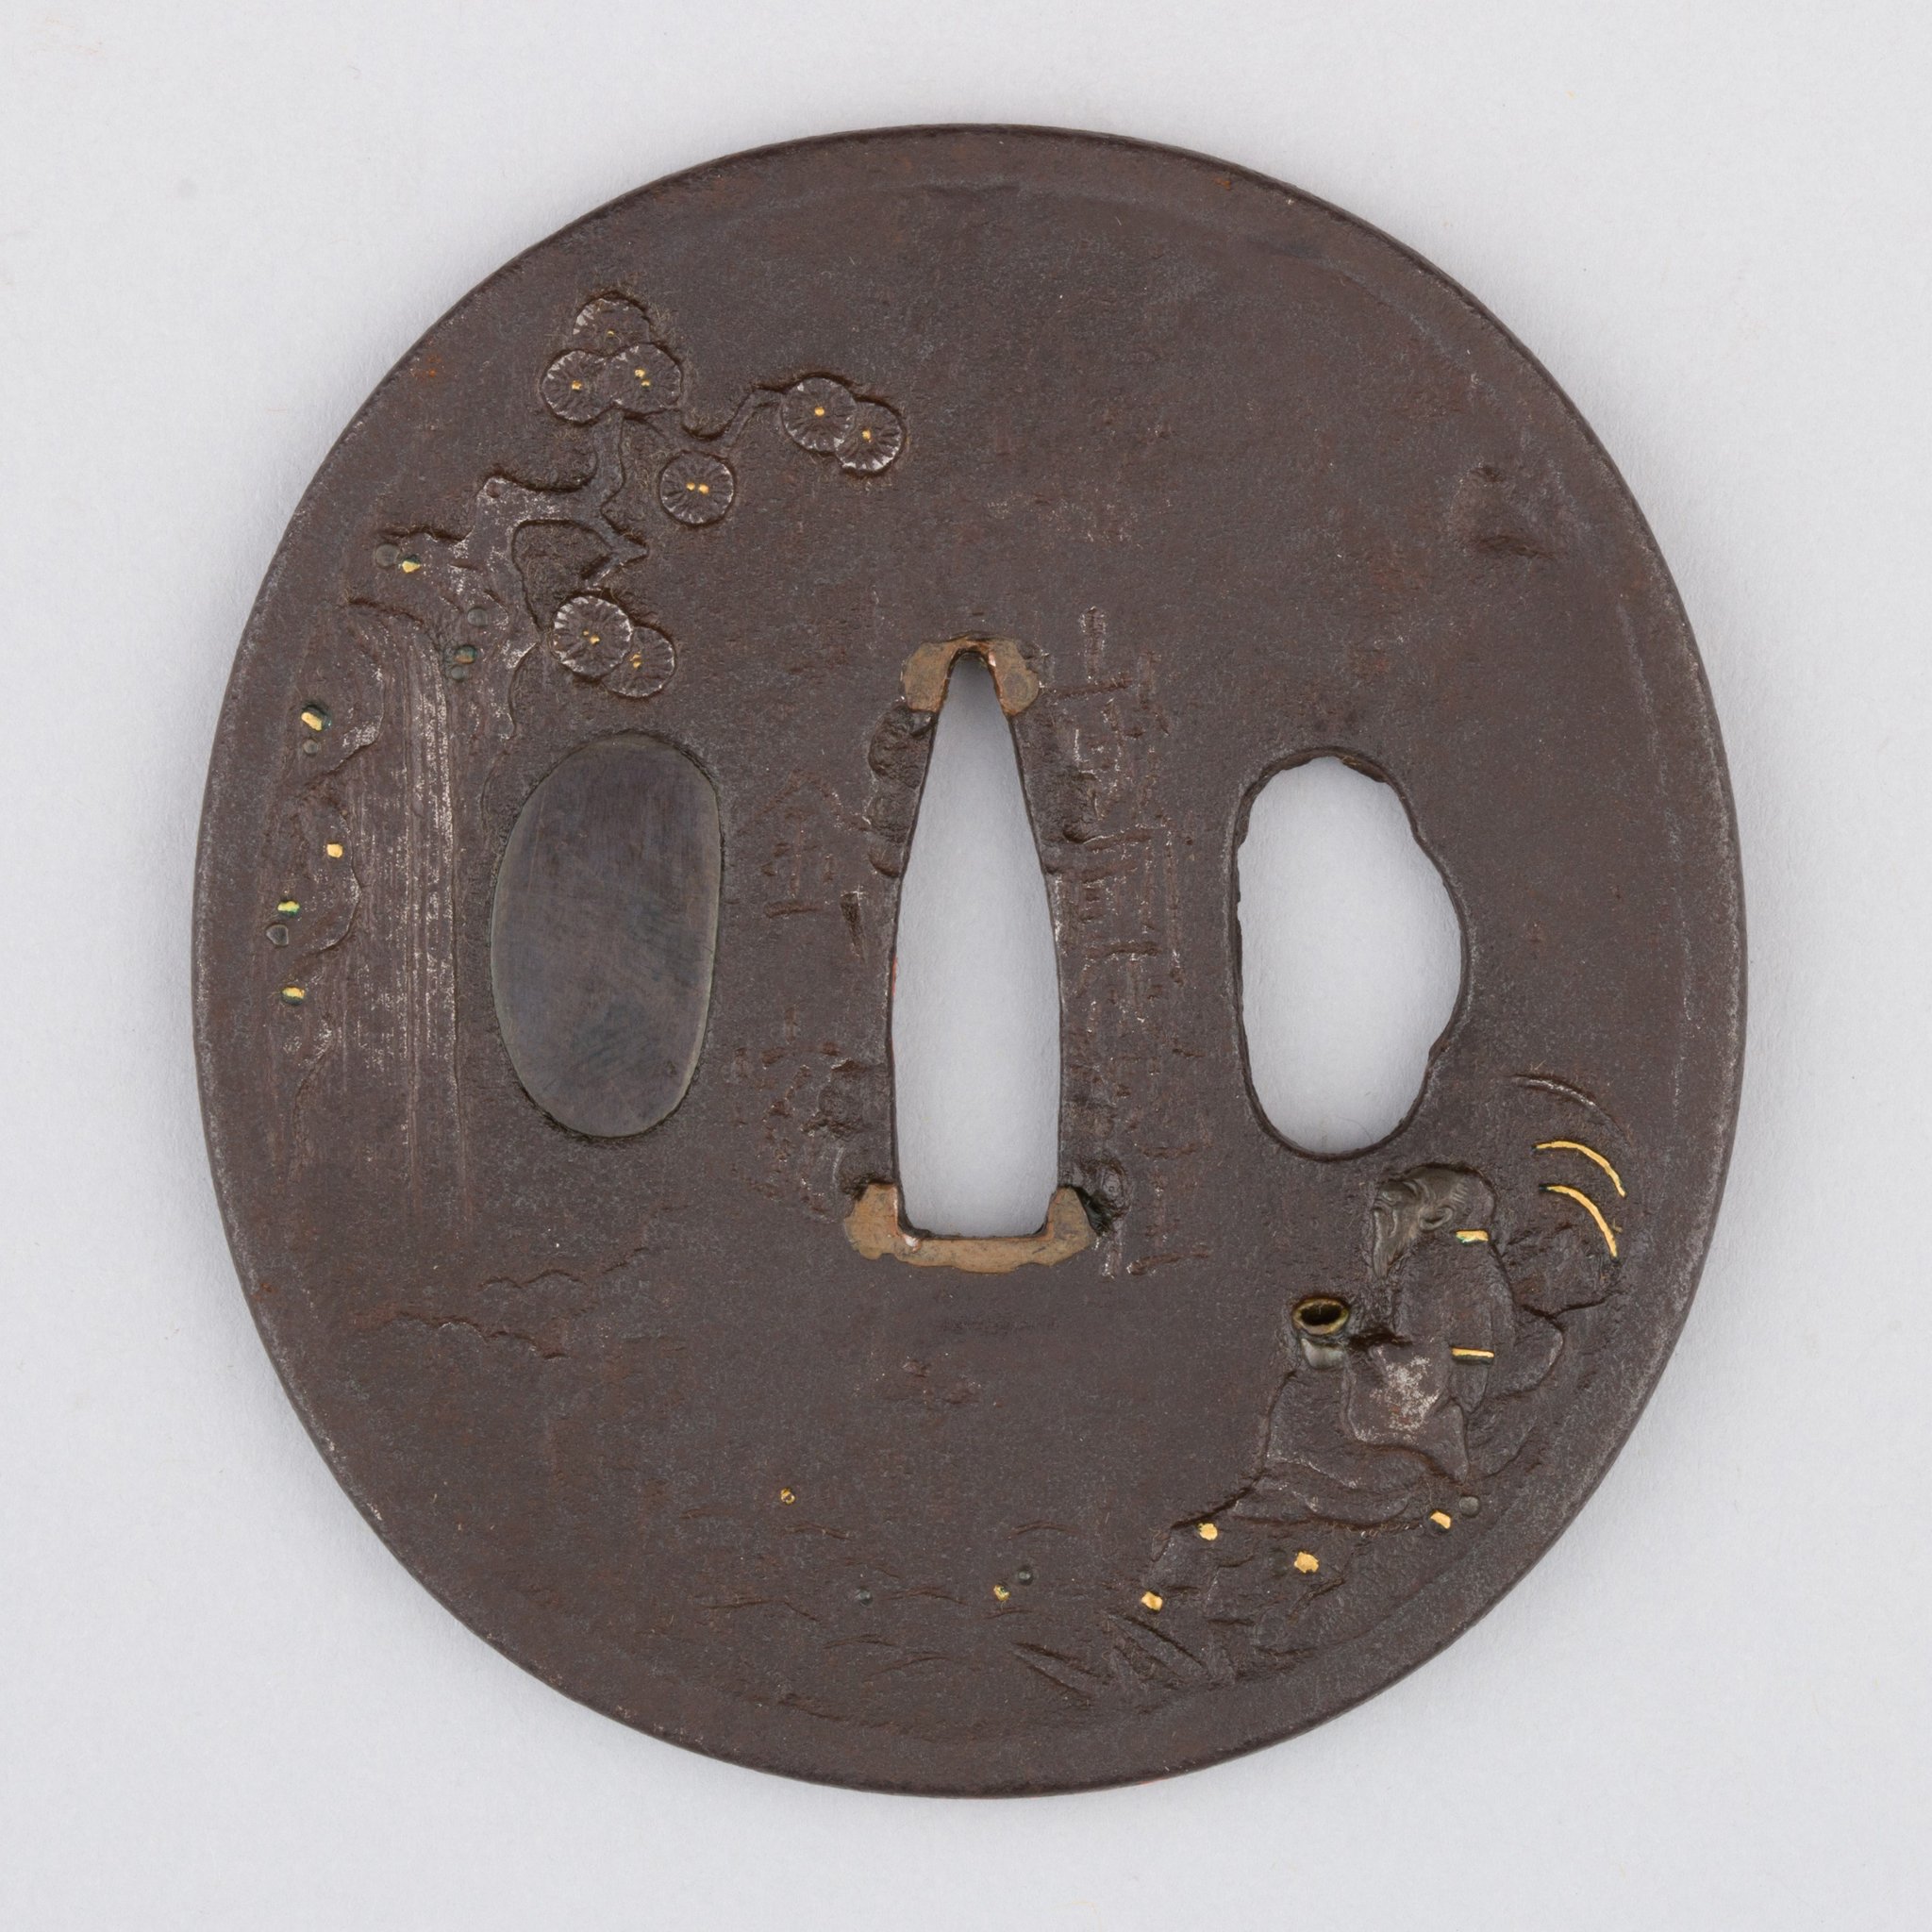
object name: sword guard tsuba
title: Sword Guard (Tsuba)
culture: japanese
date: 1615-1868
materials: copper, iron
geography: japan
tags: men